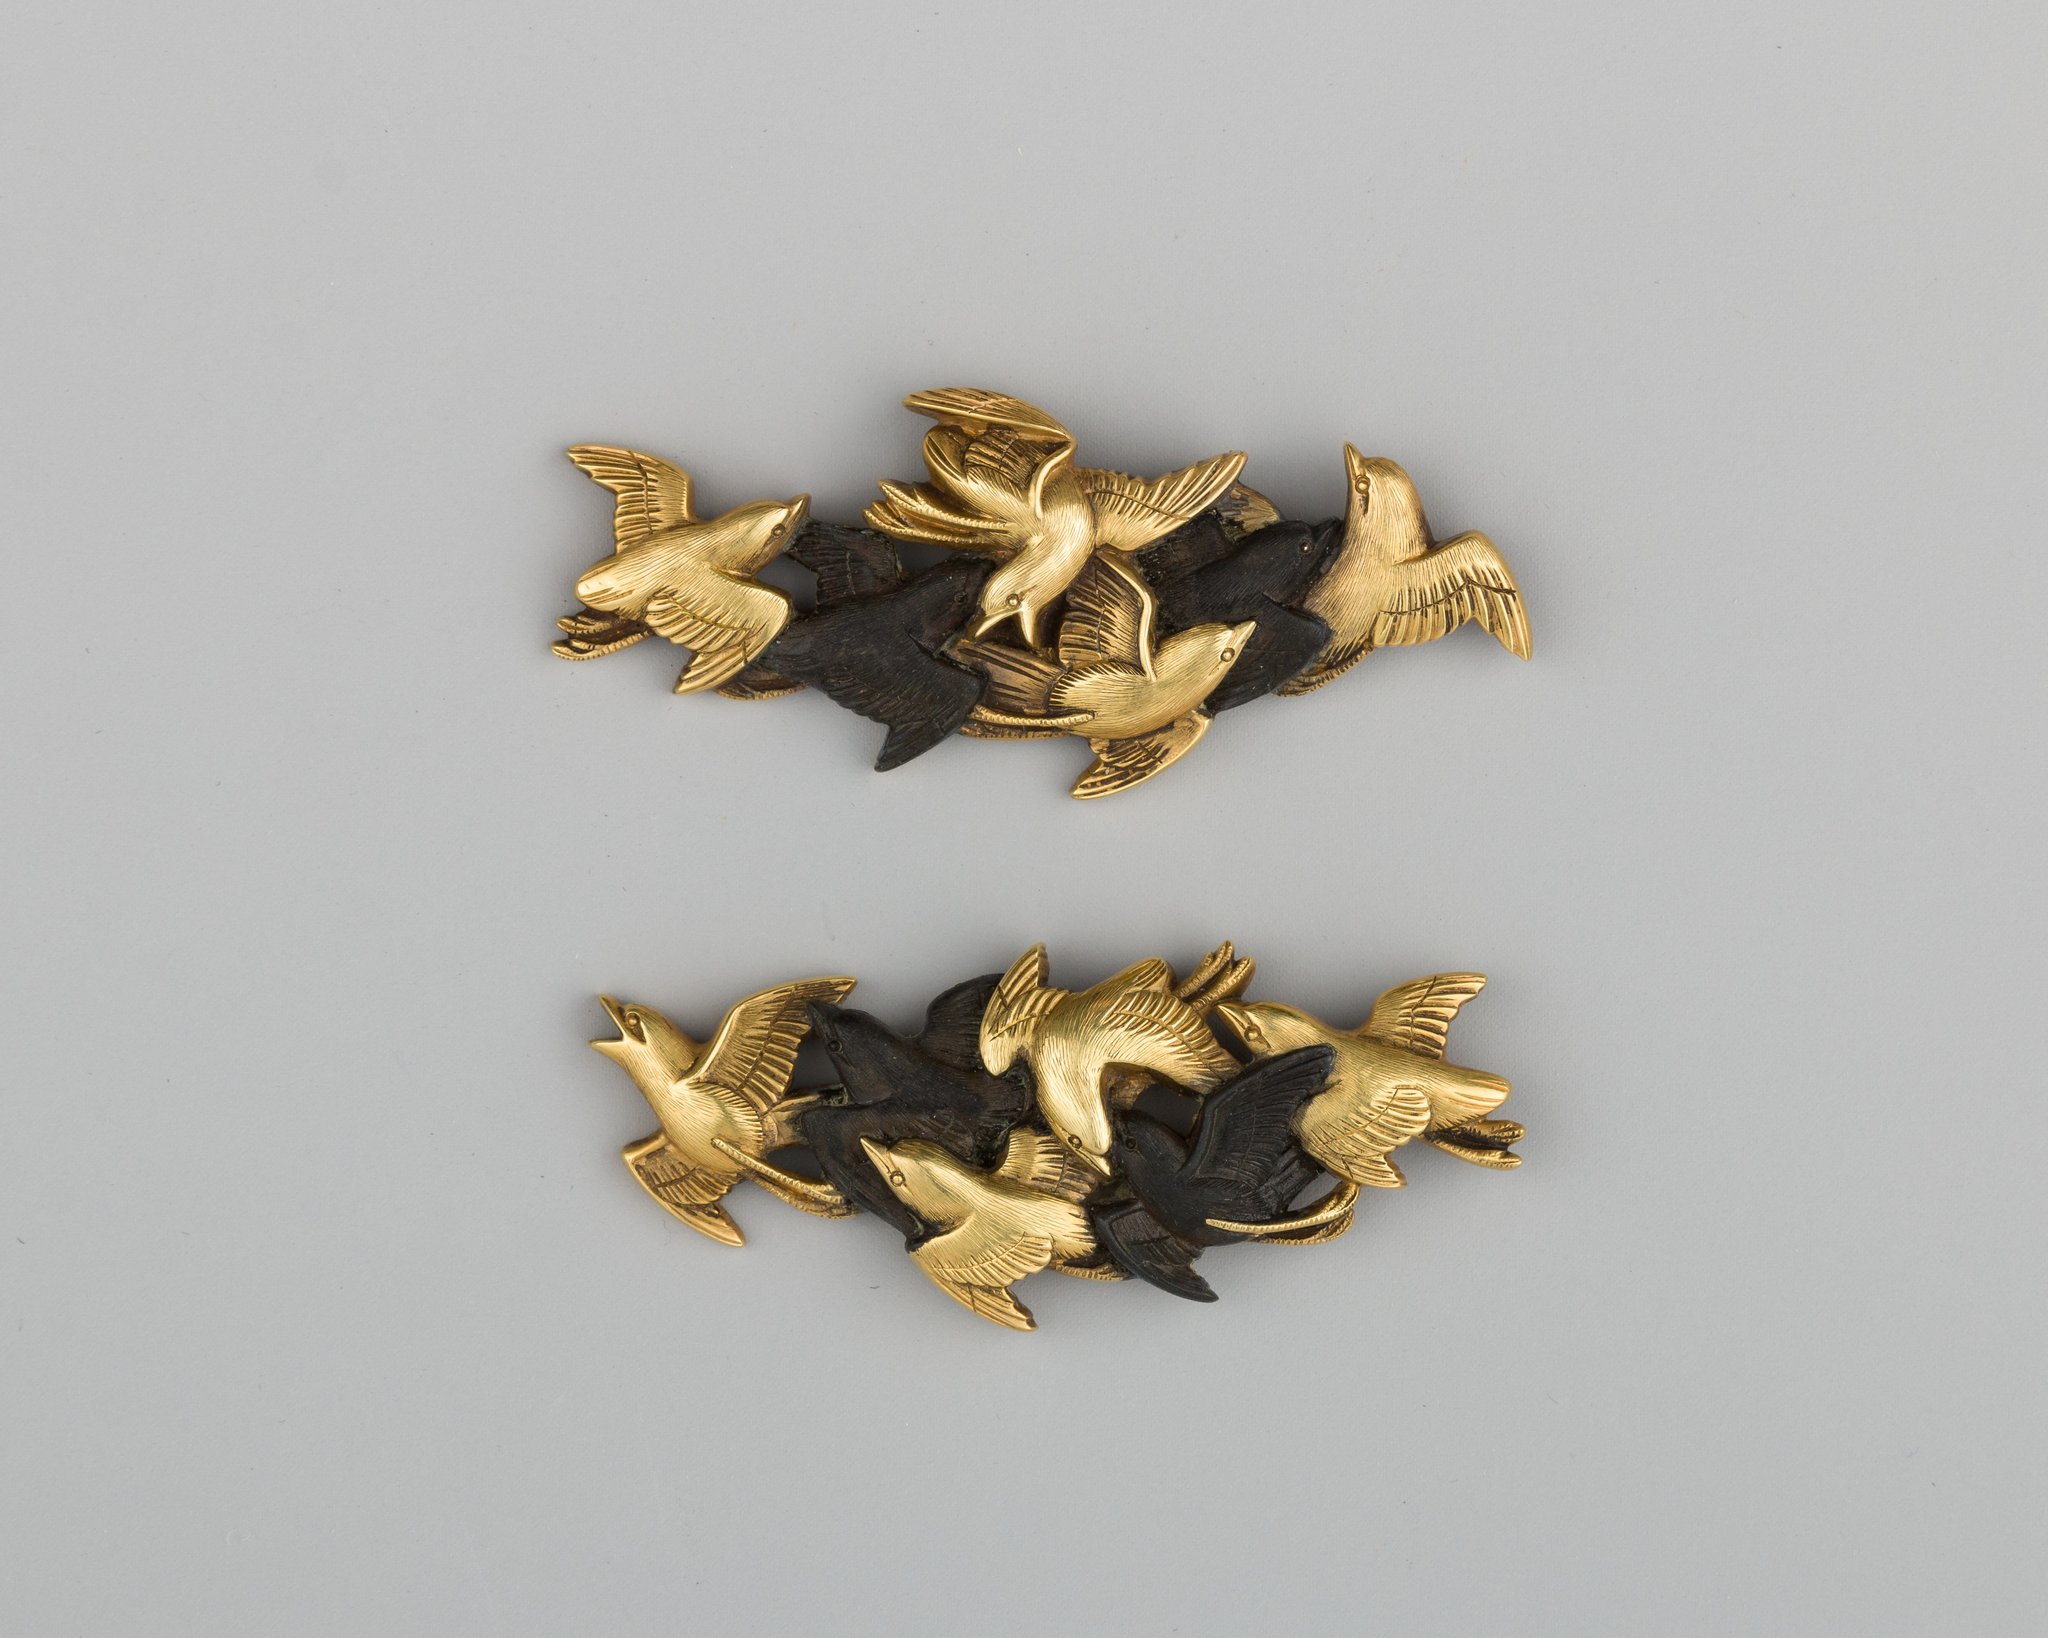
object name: pair of sword grip ornament menuki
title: Pair of Sword-Grip Ornaments (Menuki)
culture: japanese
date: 1701-1800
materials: gold alloy, gold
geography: japan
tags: birds